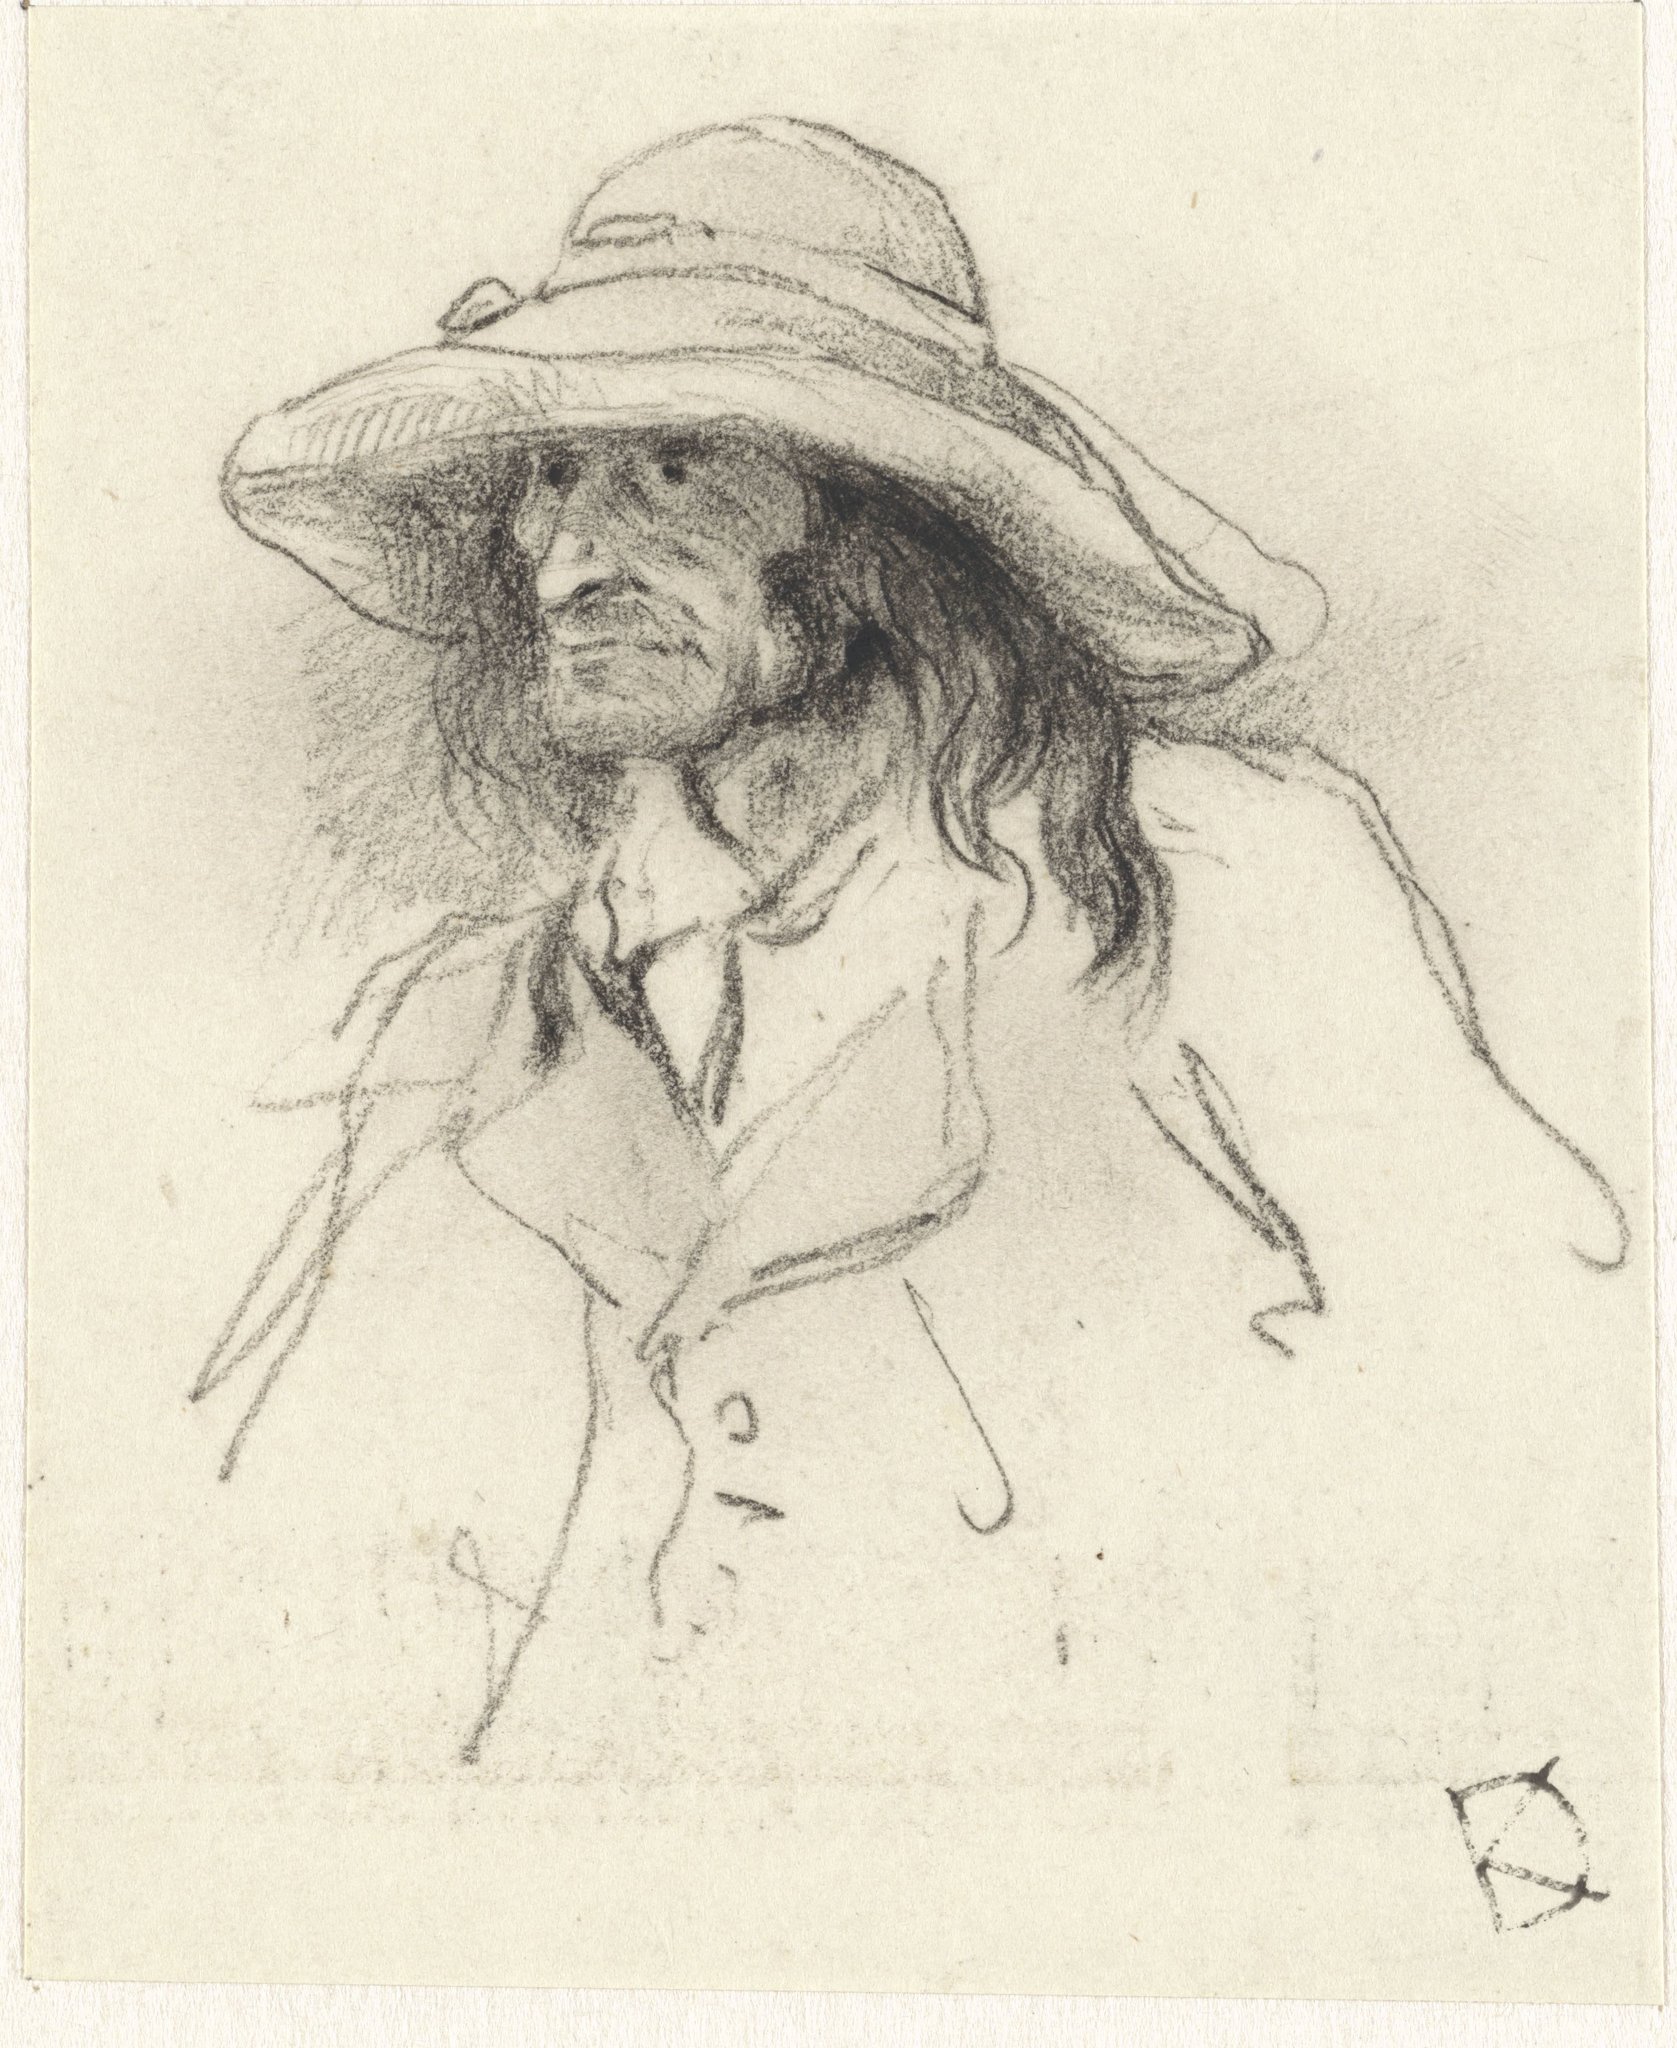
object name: drawing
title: Studie van een man met lang haar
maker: johan daniël koelman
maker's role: draughtsman, print maker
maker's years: 1831-1857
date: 1841-1857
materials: chalk, paper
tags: head-gear: hat, male sex; man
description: Studie van een man met lang haar en een hoed met een brede rand.